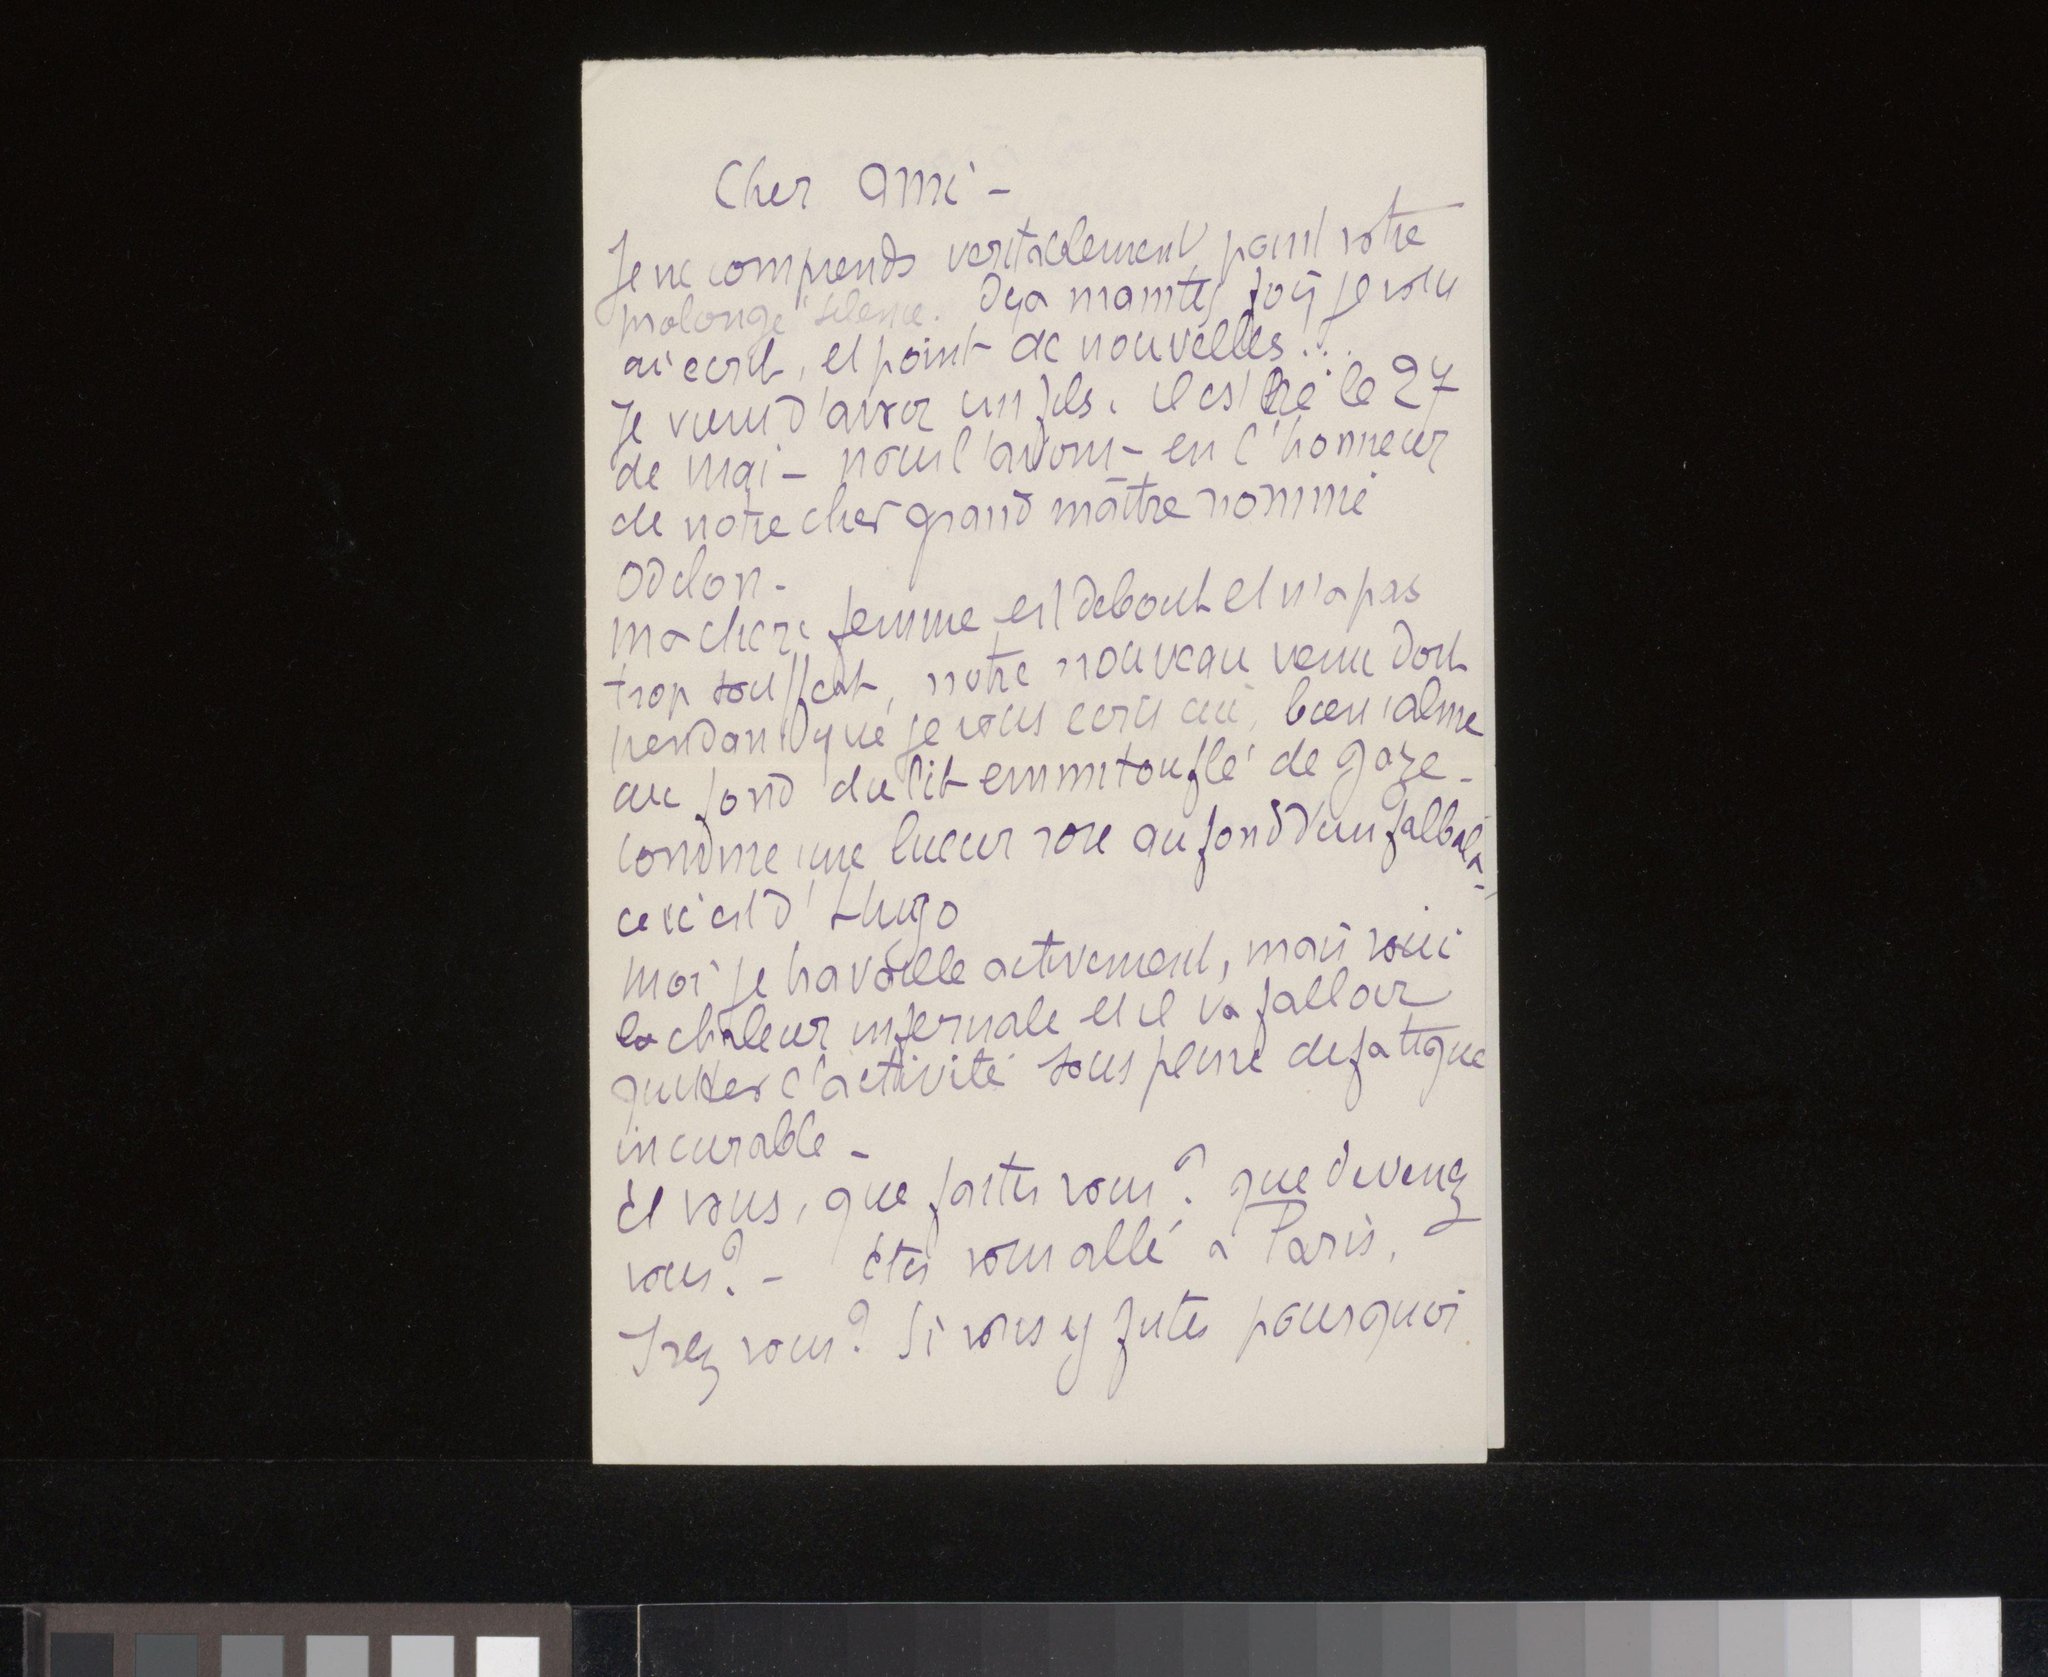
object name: letter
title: Brief aan Andries Bonger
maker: émile bernard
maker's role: print maker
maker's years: 1868-1941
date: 1898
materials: ink, paper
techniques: pen, writing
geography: cairo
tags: andries bonger, paris